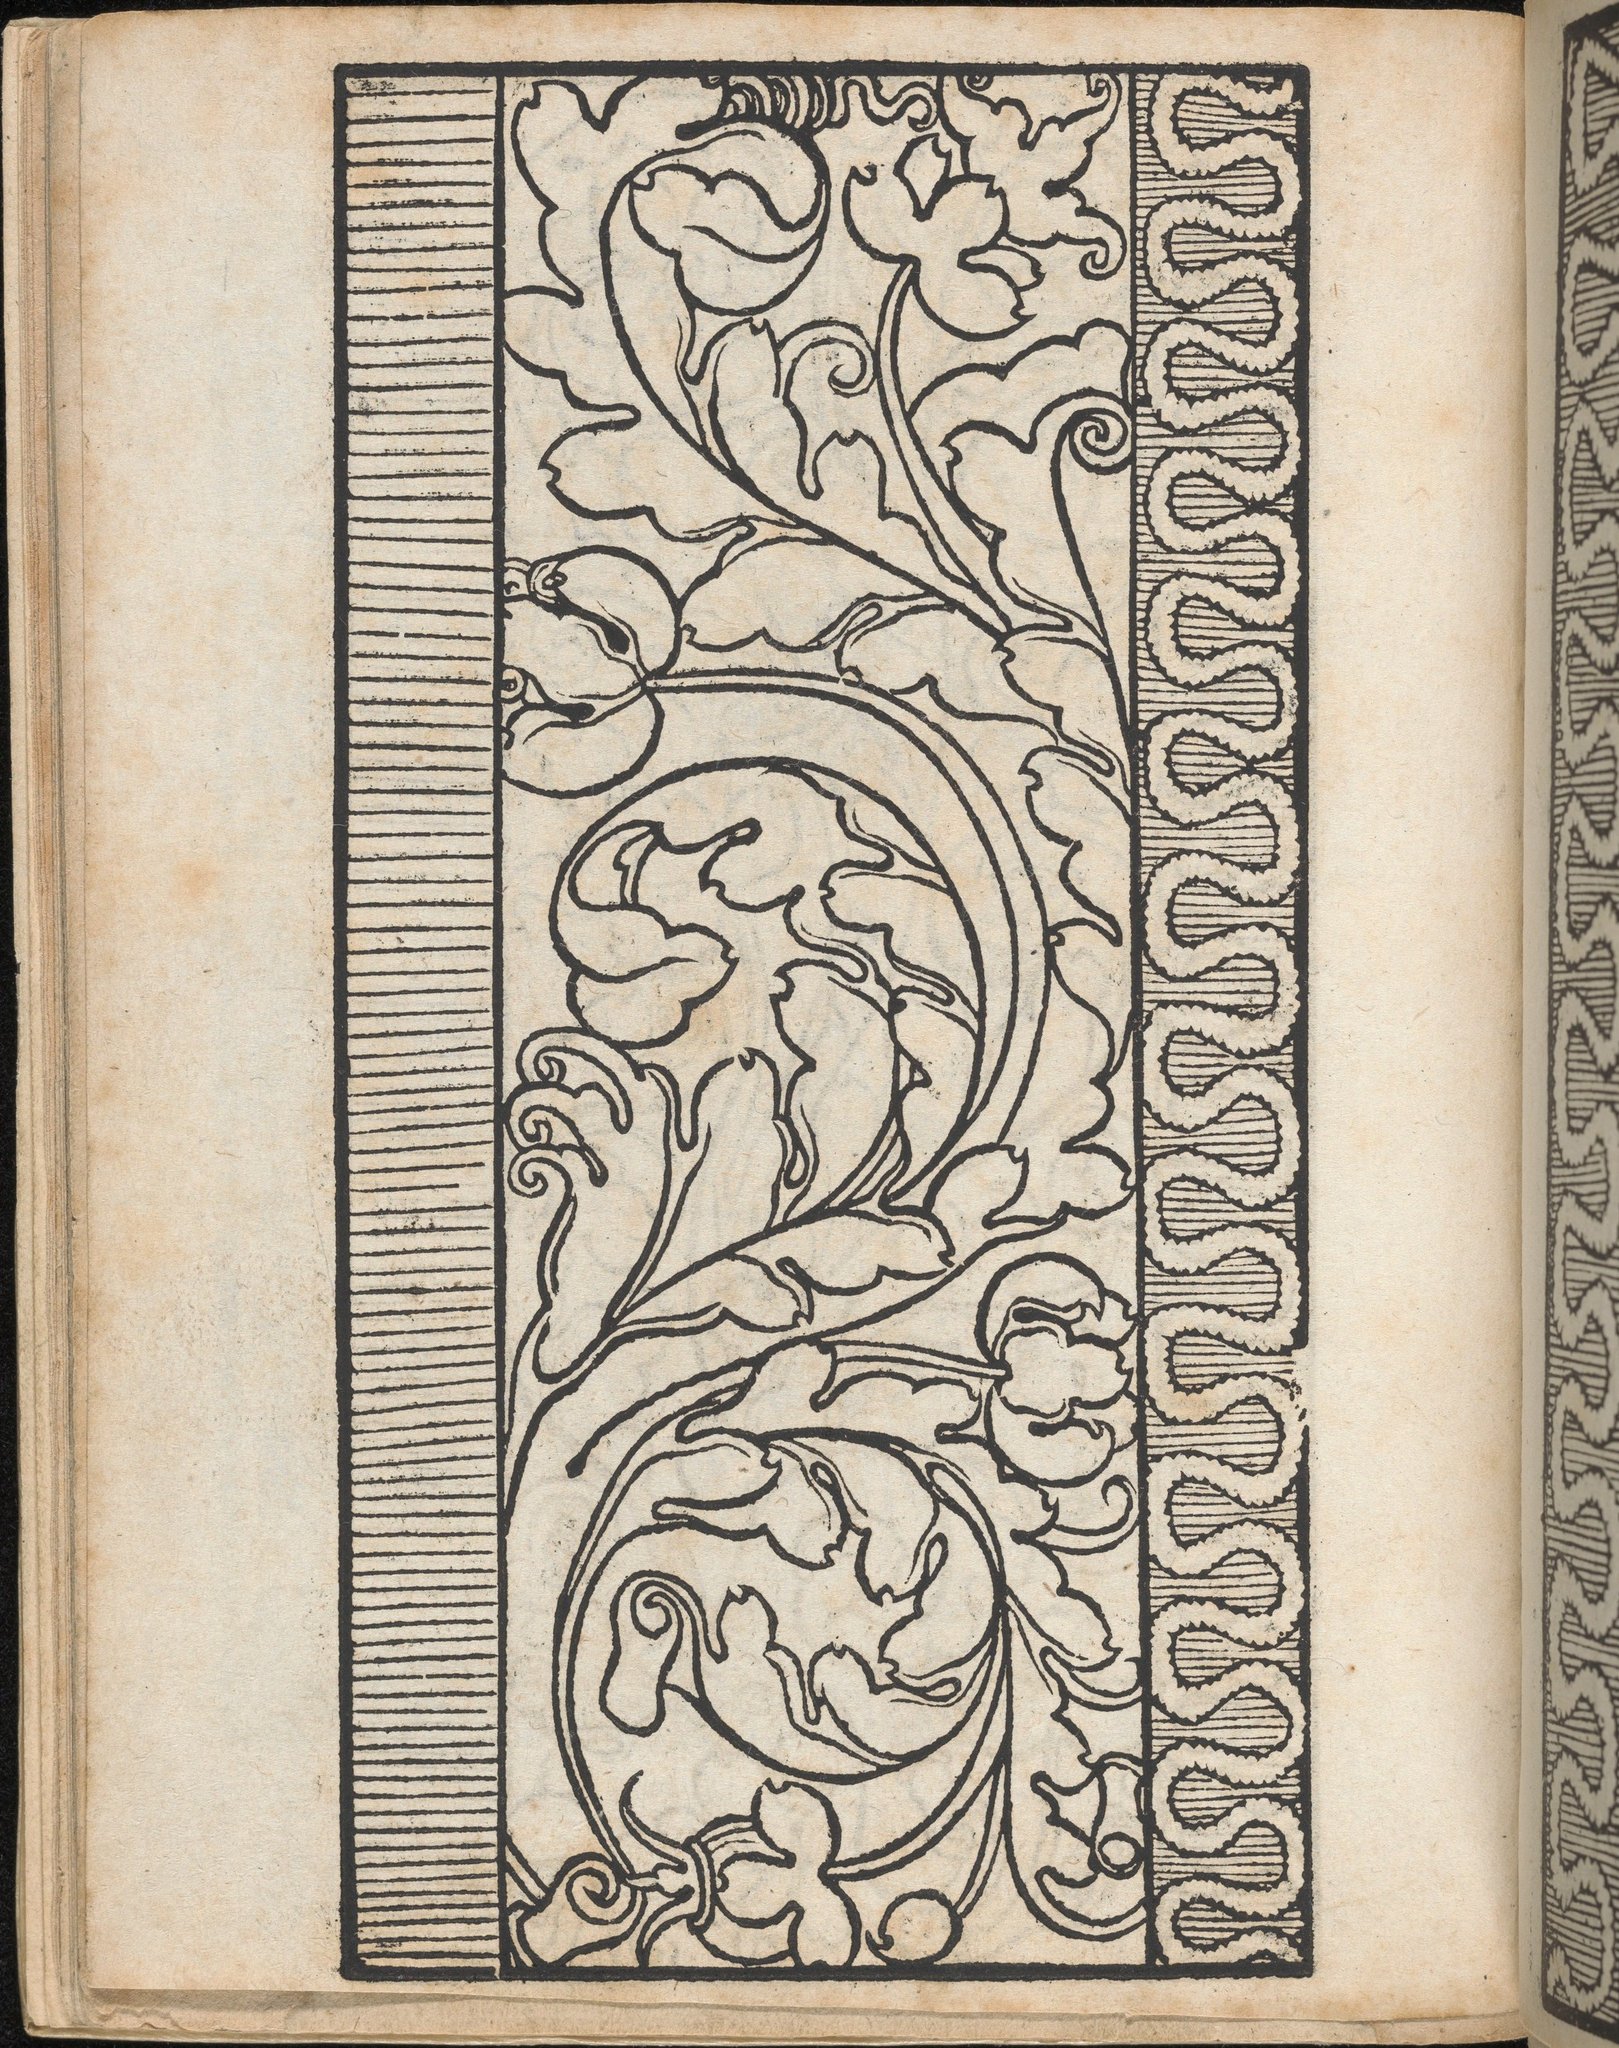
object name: book print ornament architecture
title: Ein new Modelbuch..., page 13 (verso)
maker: johann schönsperger the younger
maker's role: publisher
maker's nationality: german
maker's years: 1490-1550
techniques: woodcut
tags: acanthus